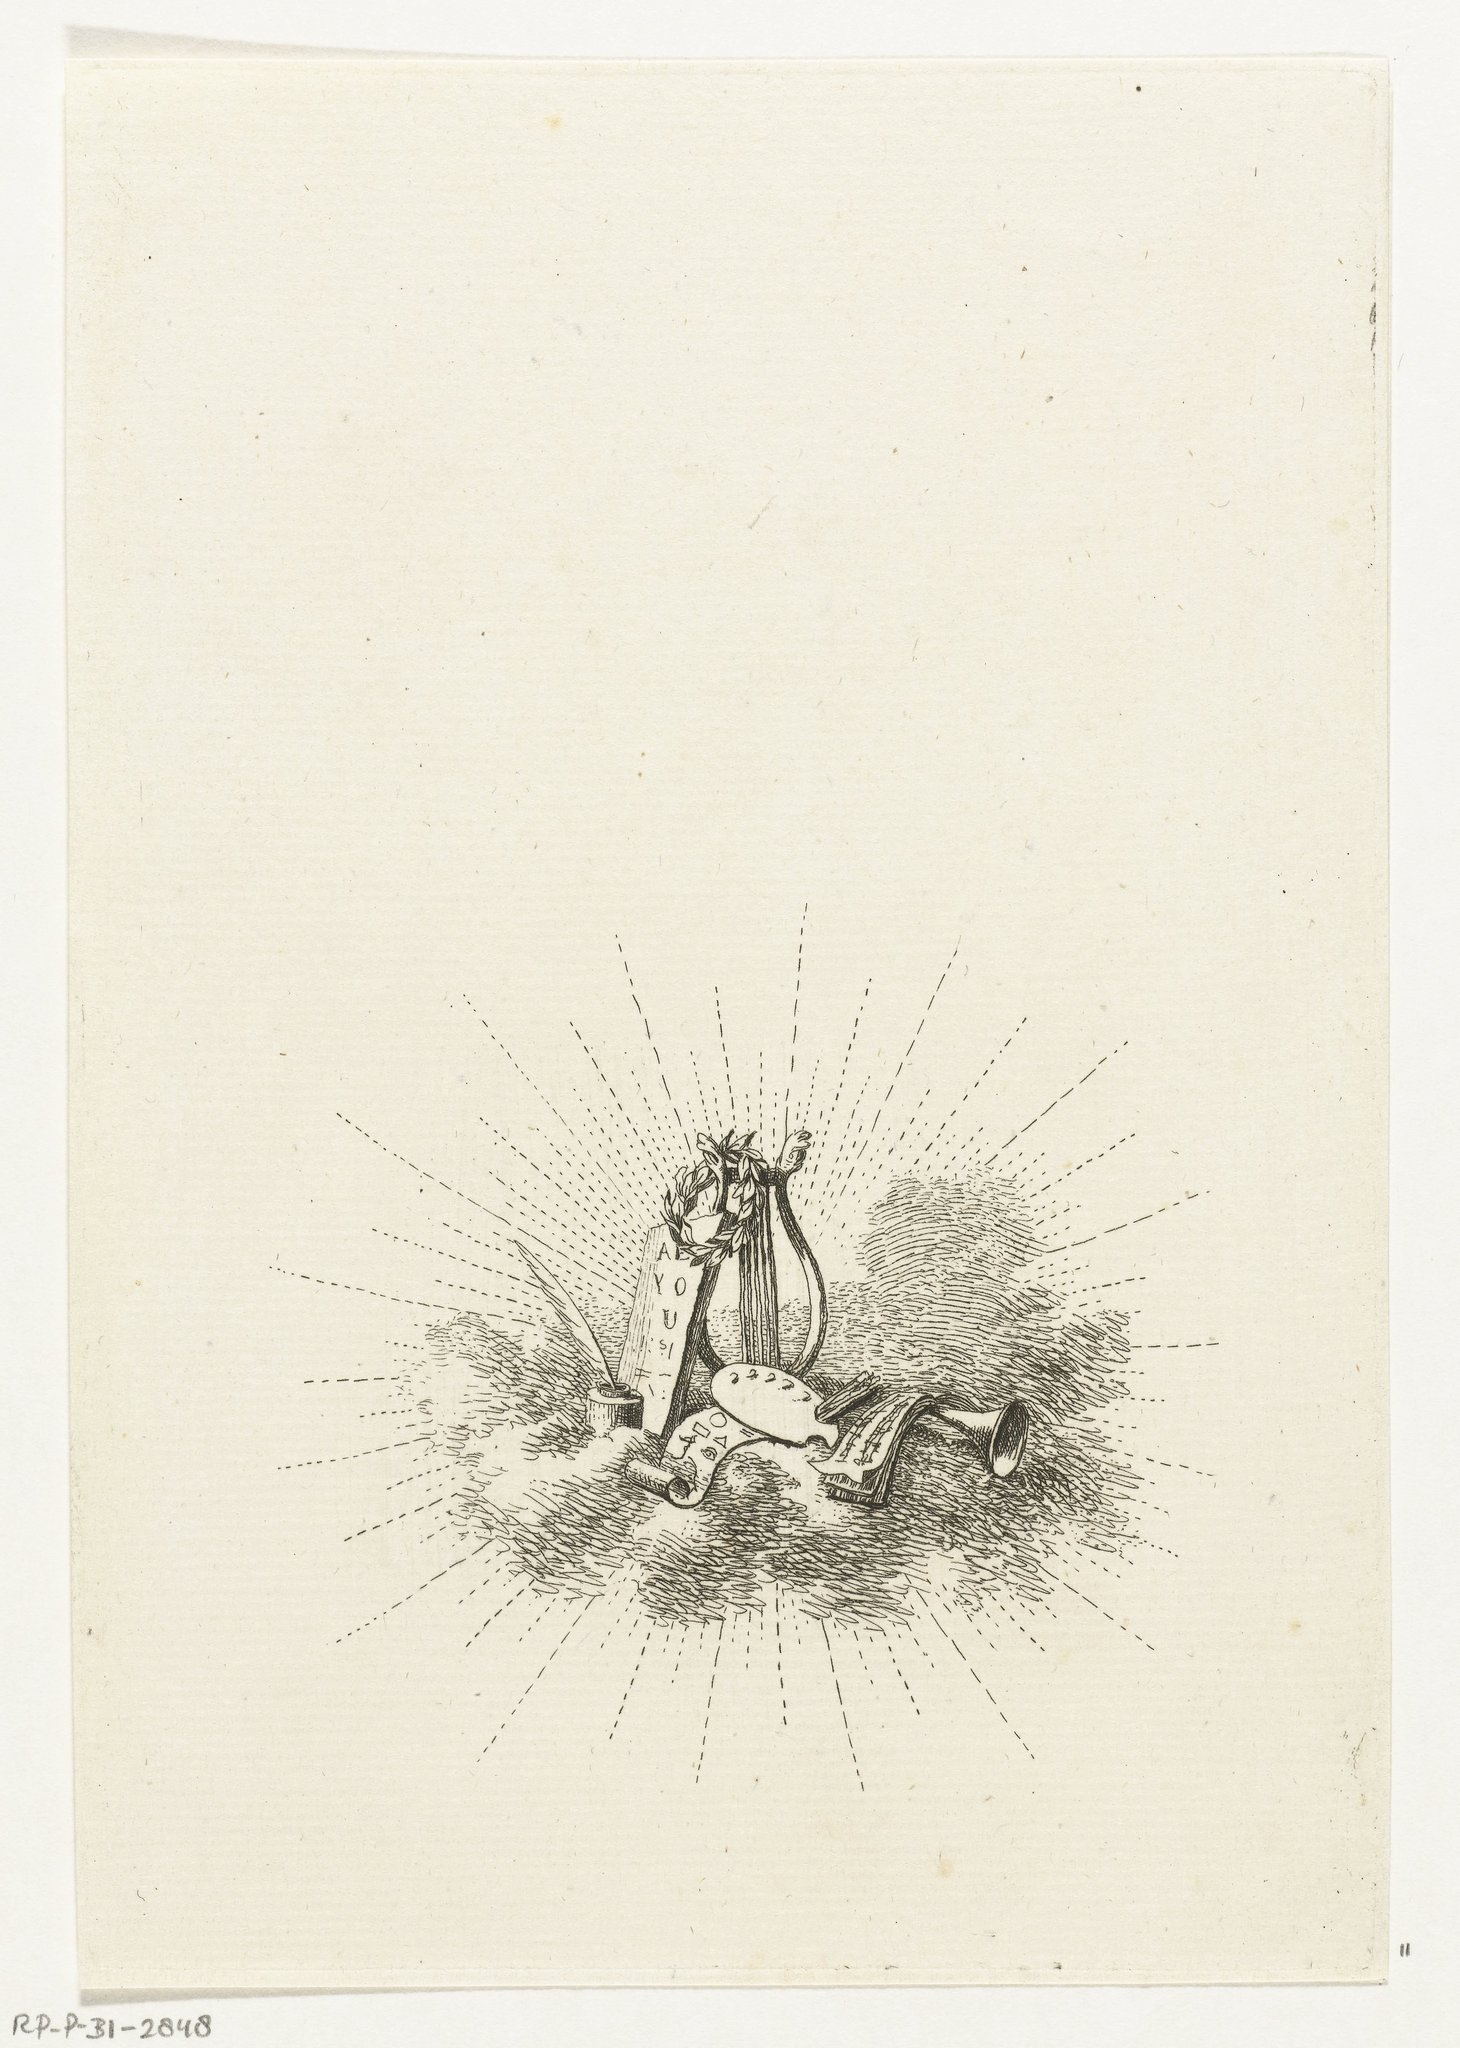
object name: print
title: Titelpagina voor: Gezangen voor het Kunstbevorderend Gezelschap V.W. opgerigt in den jare 1807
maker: anthonie van den bos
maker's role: draughtsman, print maker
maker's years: 1763-1838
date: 1807-1838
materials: paper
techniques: etching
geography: netherlands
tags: kunstbevorderend genootschap v.w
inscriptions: collector's mark: Lugt 2228